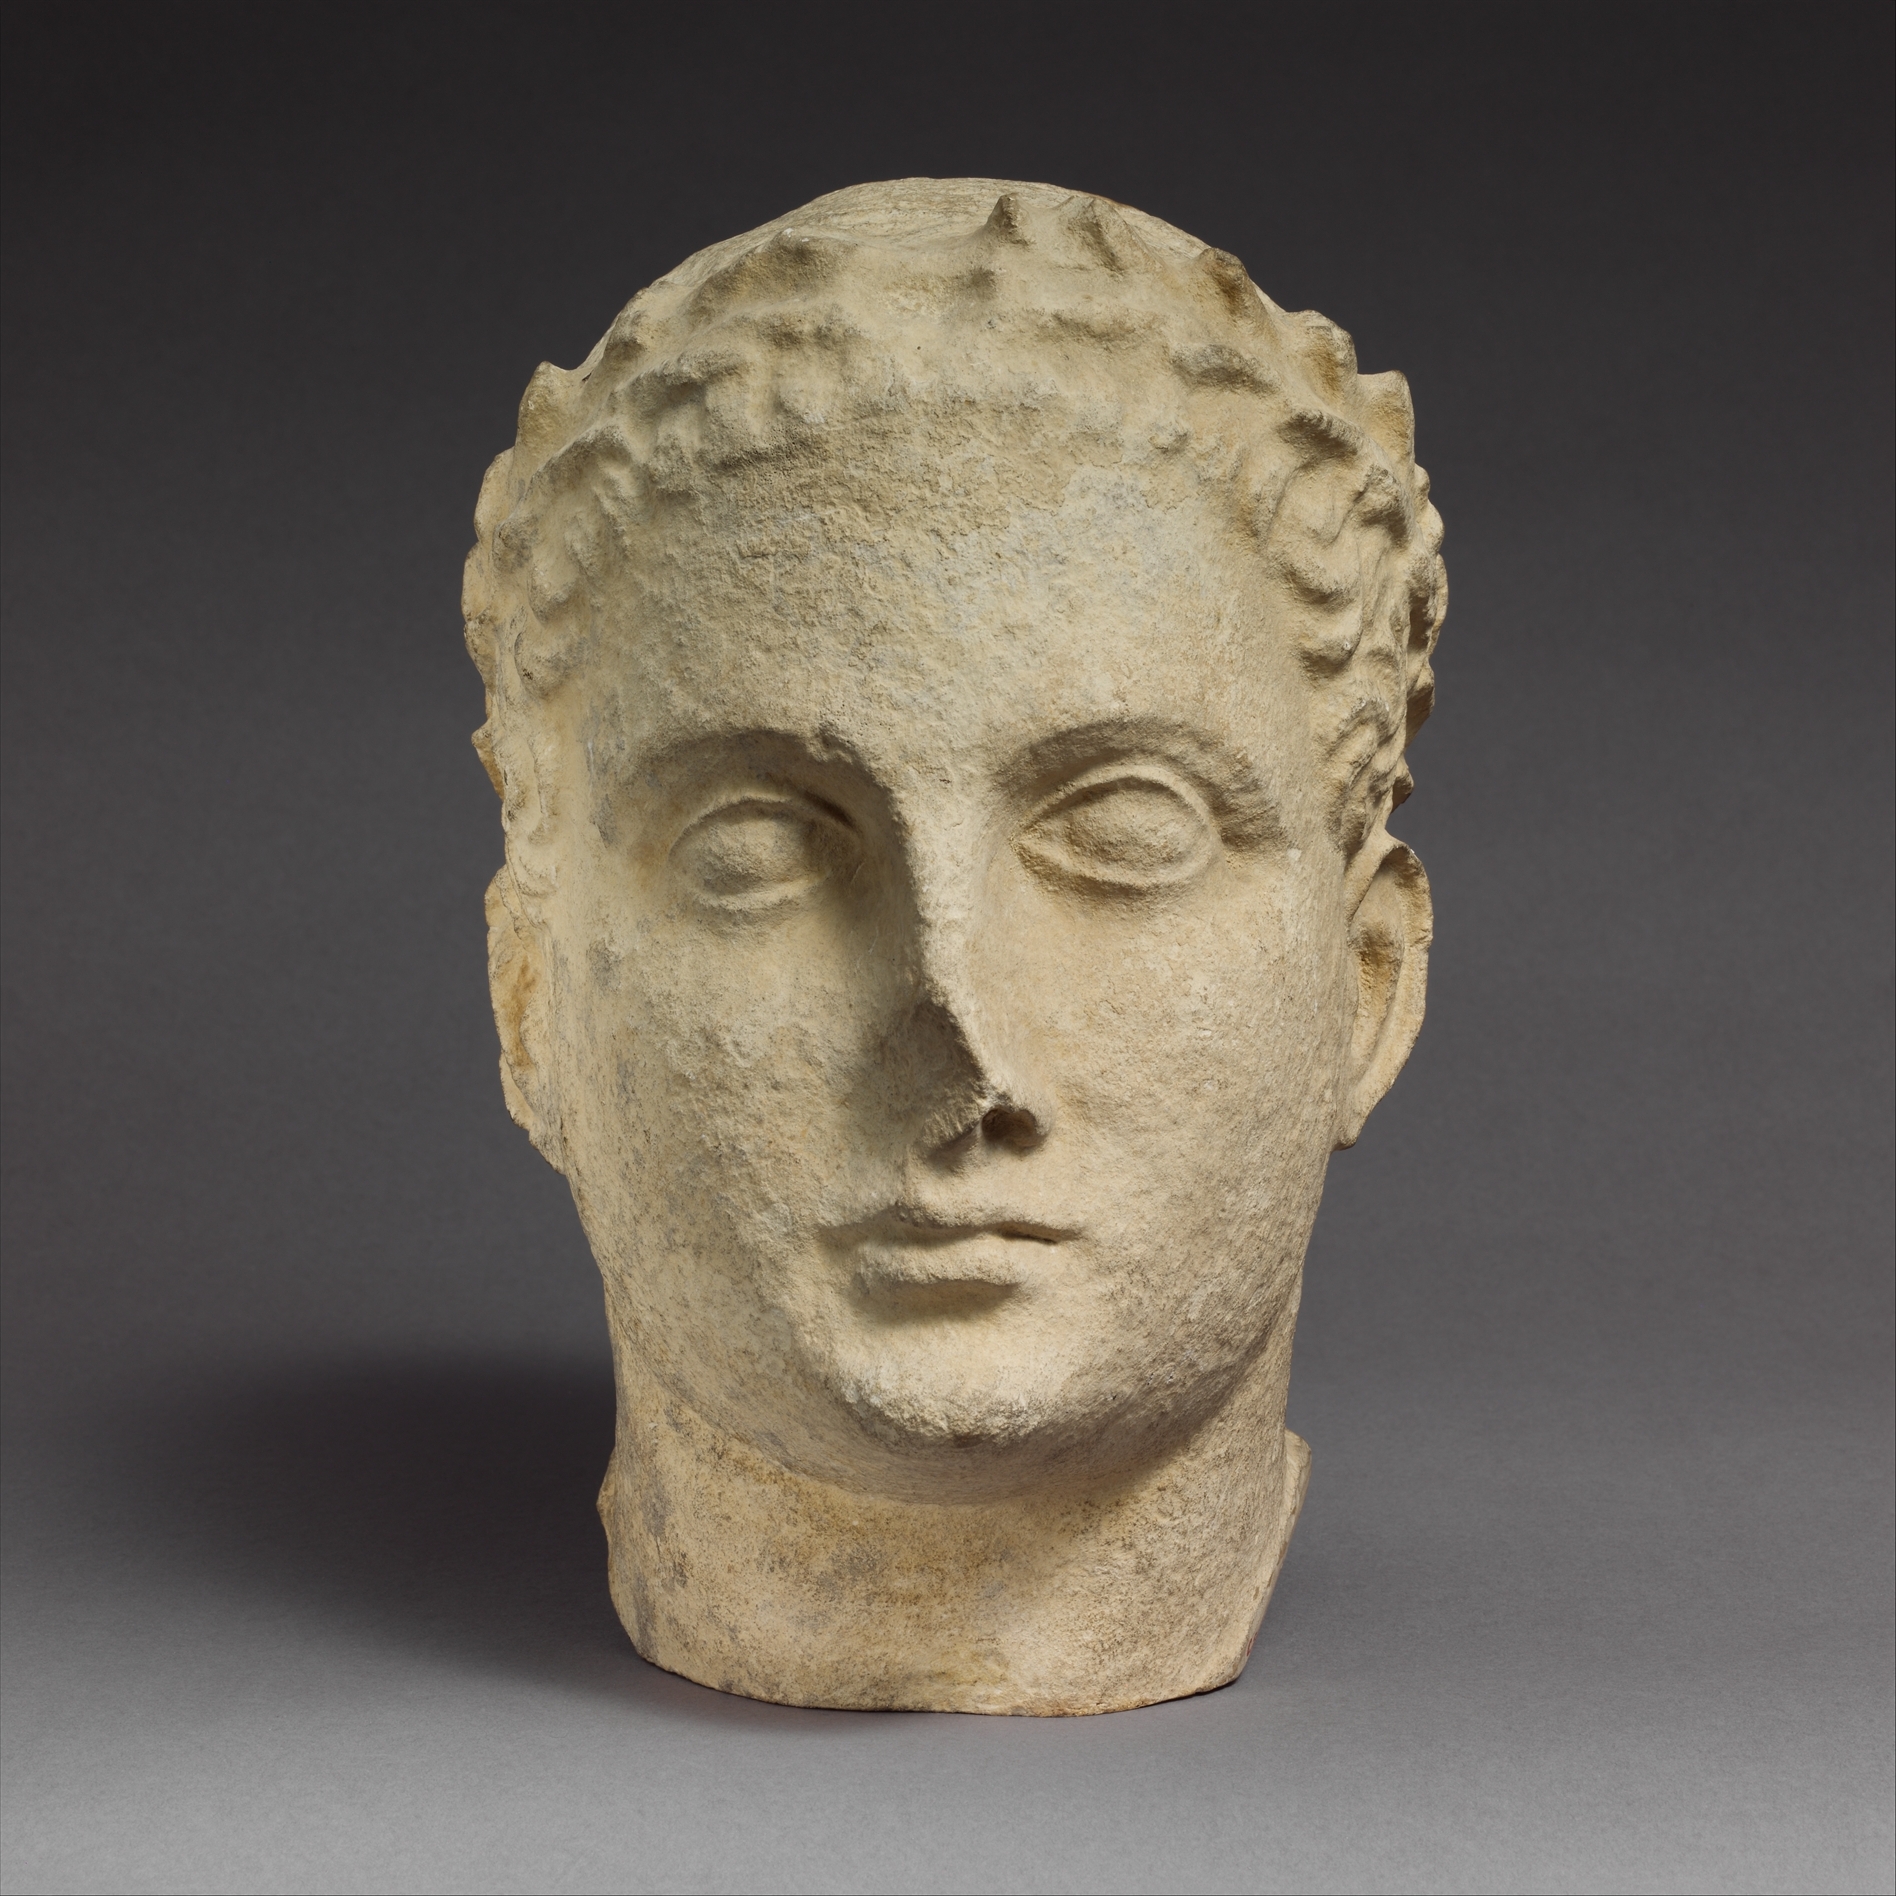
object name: head of a male votary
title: Limestone head of beardless male votary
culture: cypriot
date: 200-101 BCE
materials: limestone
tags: heads,men,wreaths